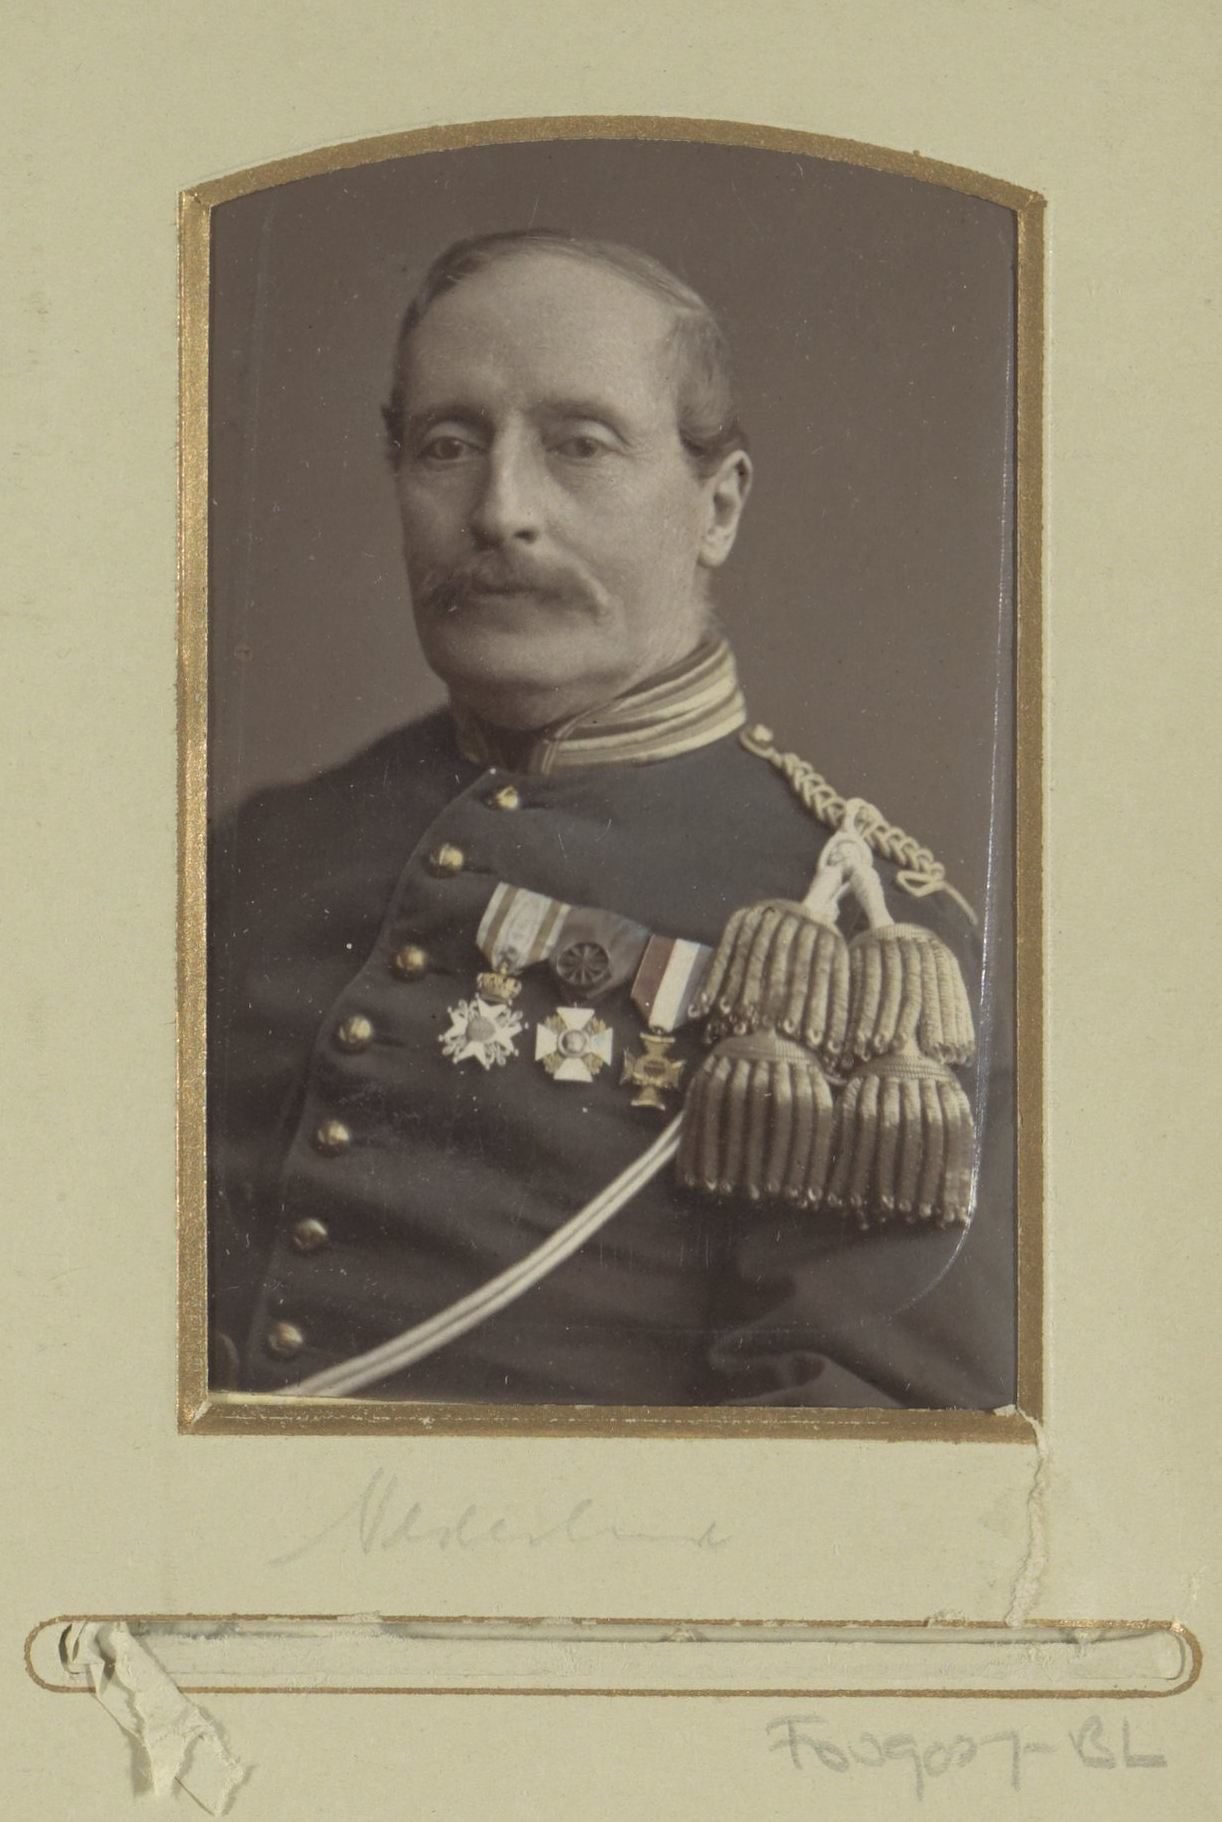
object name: album leaf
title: Portret van een (vermoedelijk) Nederlandse militair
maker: albert greiner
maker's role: fotograaf, fotostudio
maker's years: 1833-1890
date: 1875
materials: cardboard, paper, photographic support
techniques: carbon print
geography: amsterdam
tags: warfare; military affairs, (military) uniforms, division of armed forces, amsterdam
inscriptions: address: ‘Amsterdam Nieuwendijk L. 89.’, inscription: ‘1875’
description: Onderdeel van Album met cartes-de-visite en kabinetfoto's van militairen in uniform.